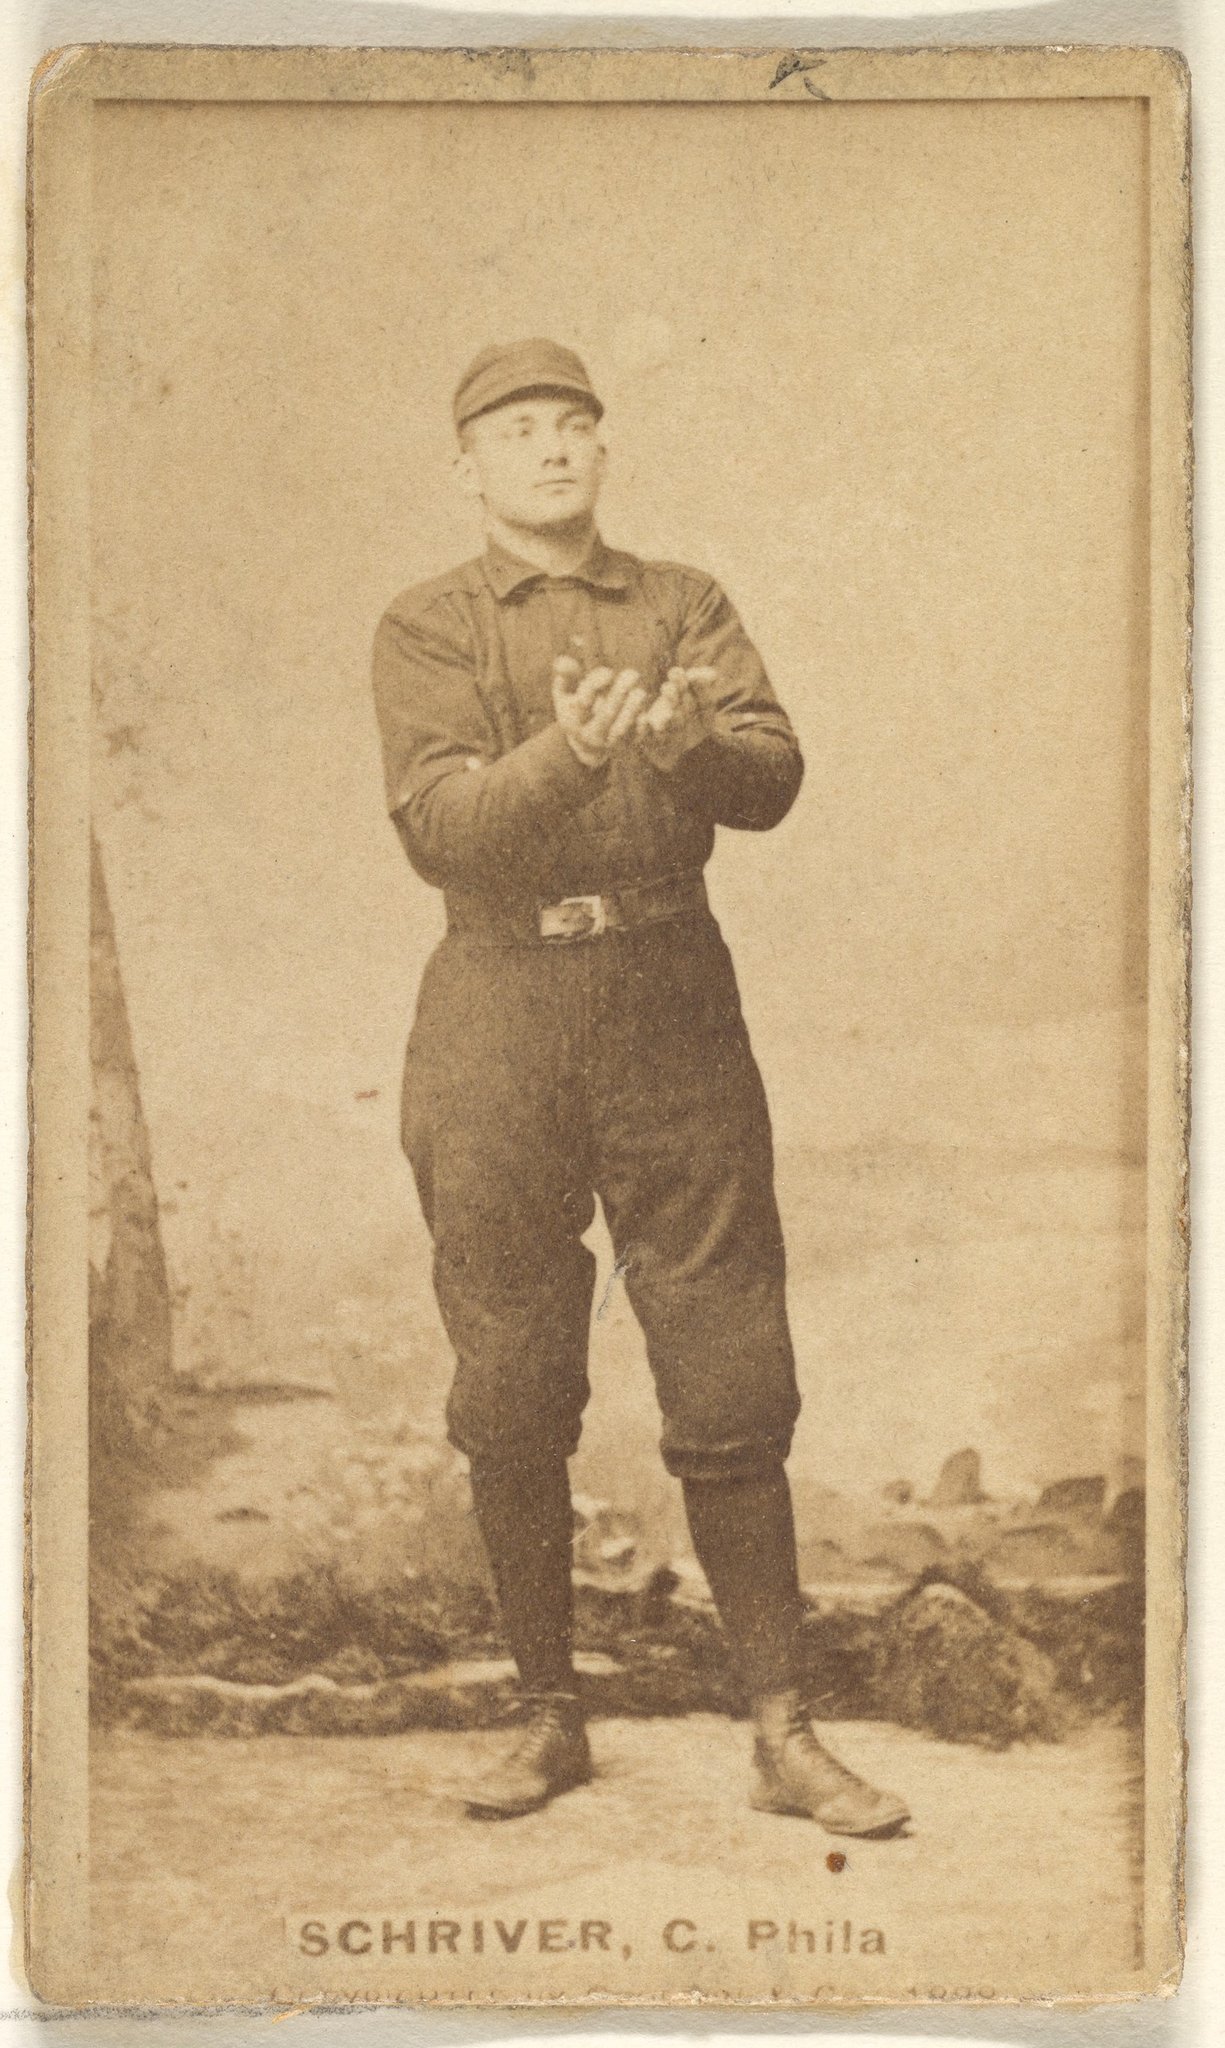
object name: baseball card, photograph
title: William Frederick "Pop" Schriver, Catcher, Philadelphia, from the Old Judge series (N172) for Old Judge Cigarettes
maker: goodwin & company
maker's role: publisher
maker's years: 1850-1950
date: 1887-1890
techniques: albumen silver print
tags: men,portraits,baseball,athletes